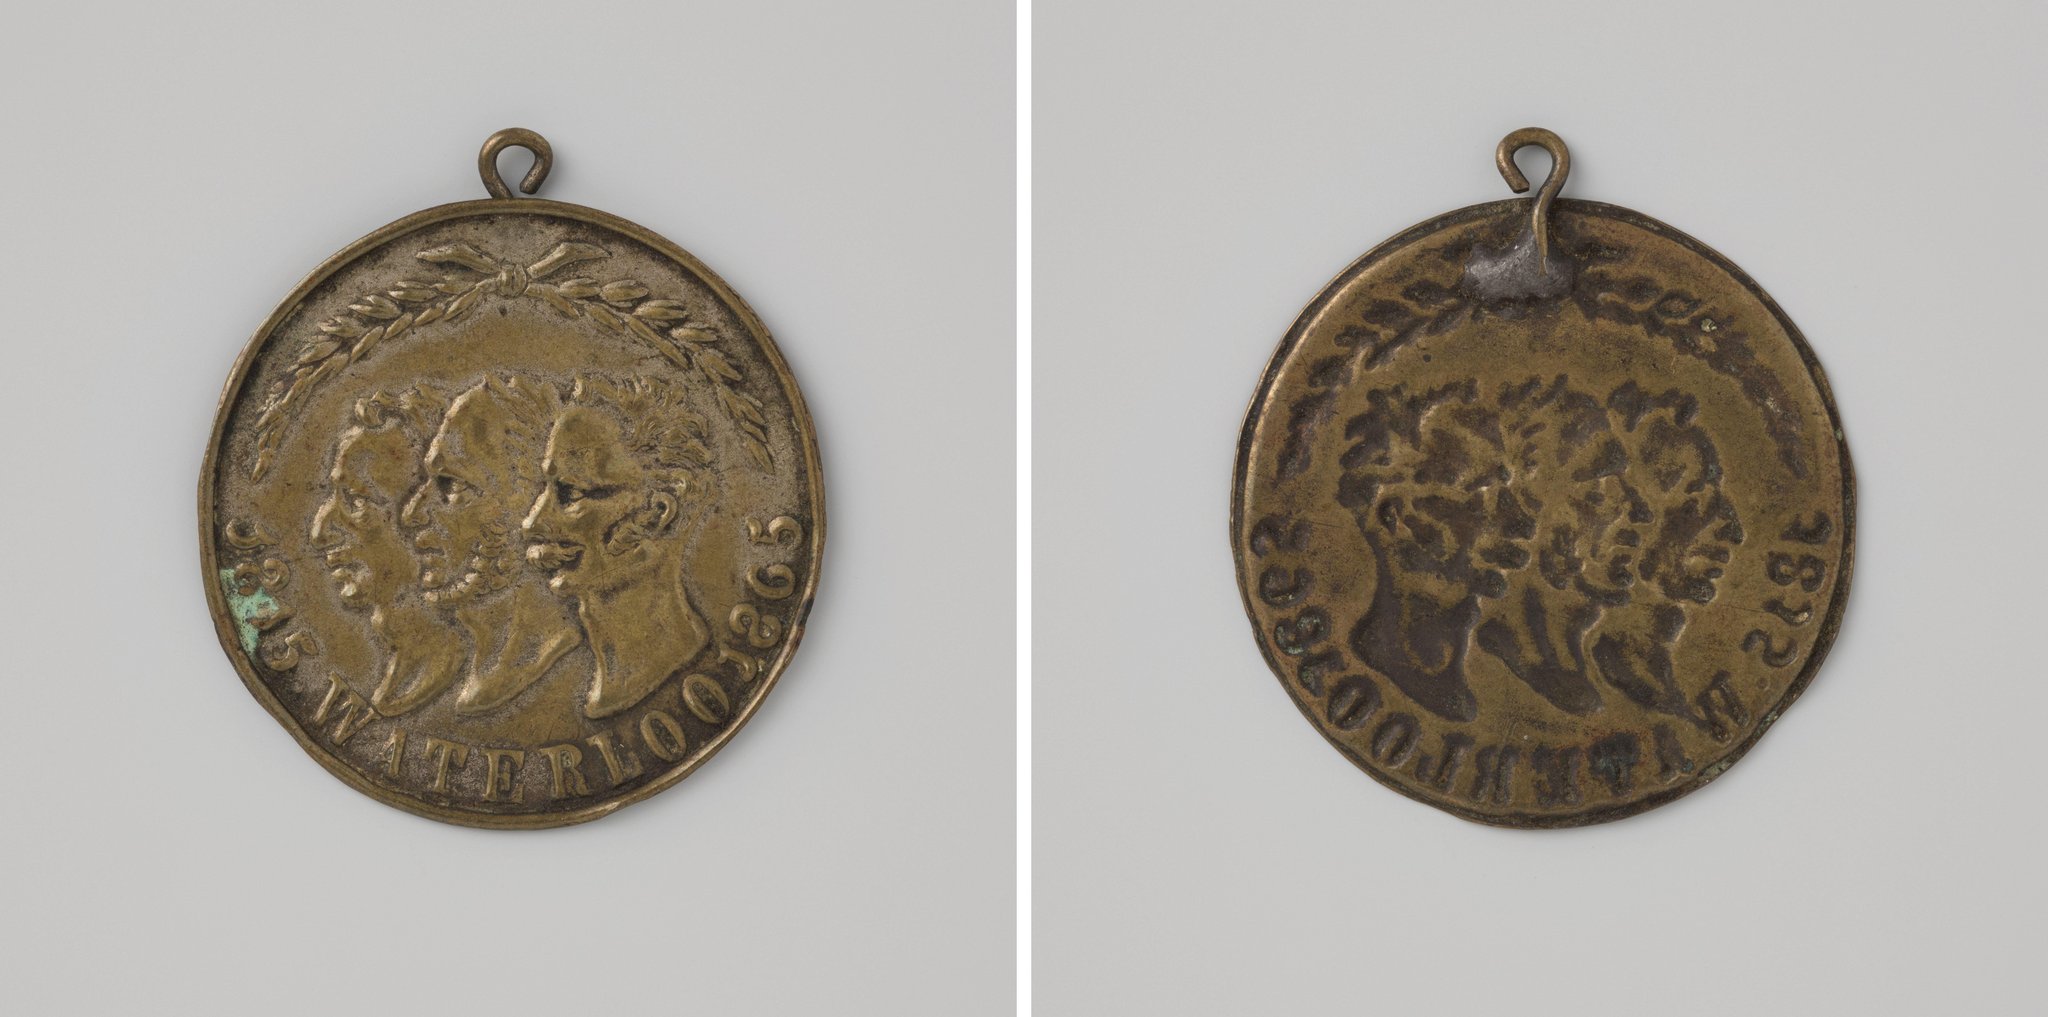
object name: history medal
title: Vijftigjarige herdenking van de Slag bij Waterloo 1865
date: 1865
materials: brass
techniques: pressing, soldering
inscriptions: circumscription: ‘1815 WATERLOO 1865’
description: Draagteken van messingblik met aangesoldeerd draagoogje, waarop de portretten van Wellington, Koning Willem II en Blücher naar links onder samengebonden lauwertakken, met onderaan omschrift.